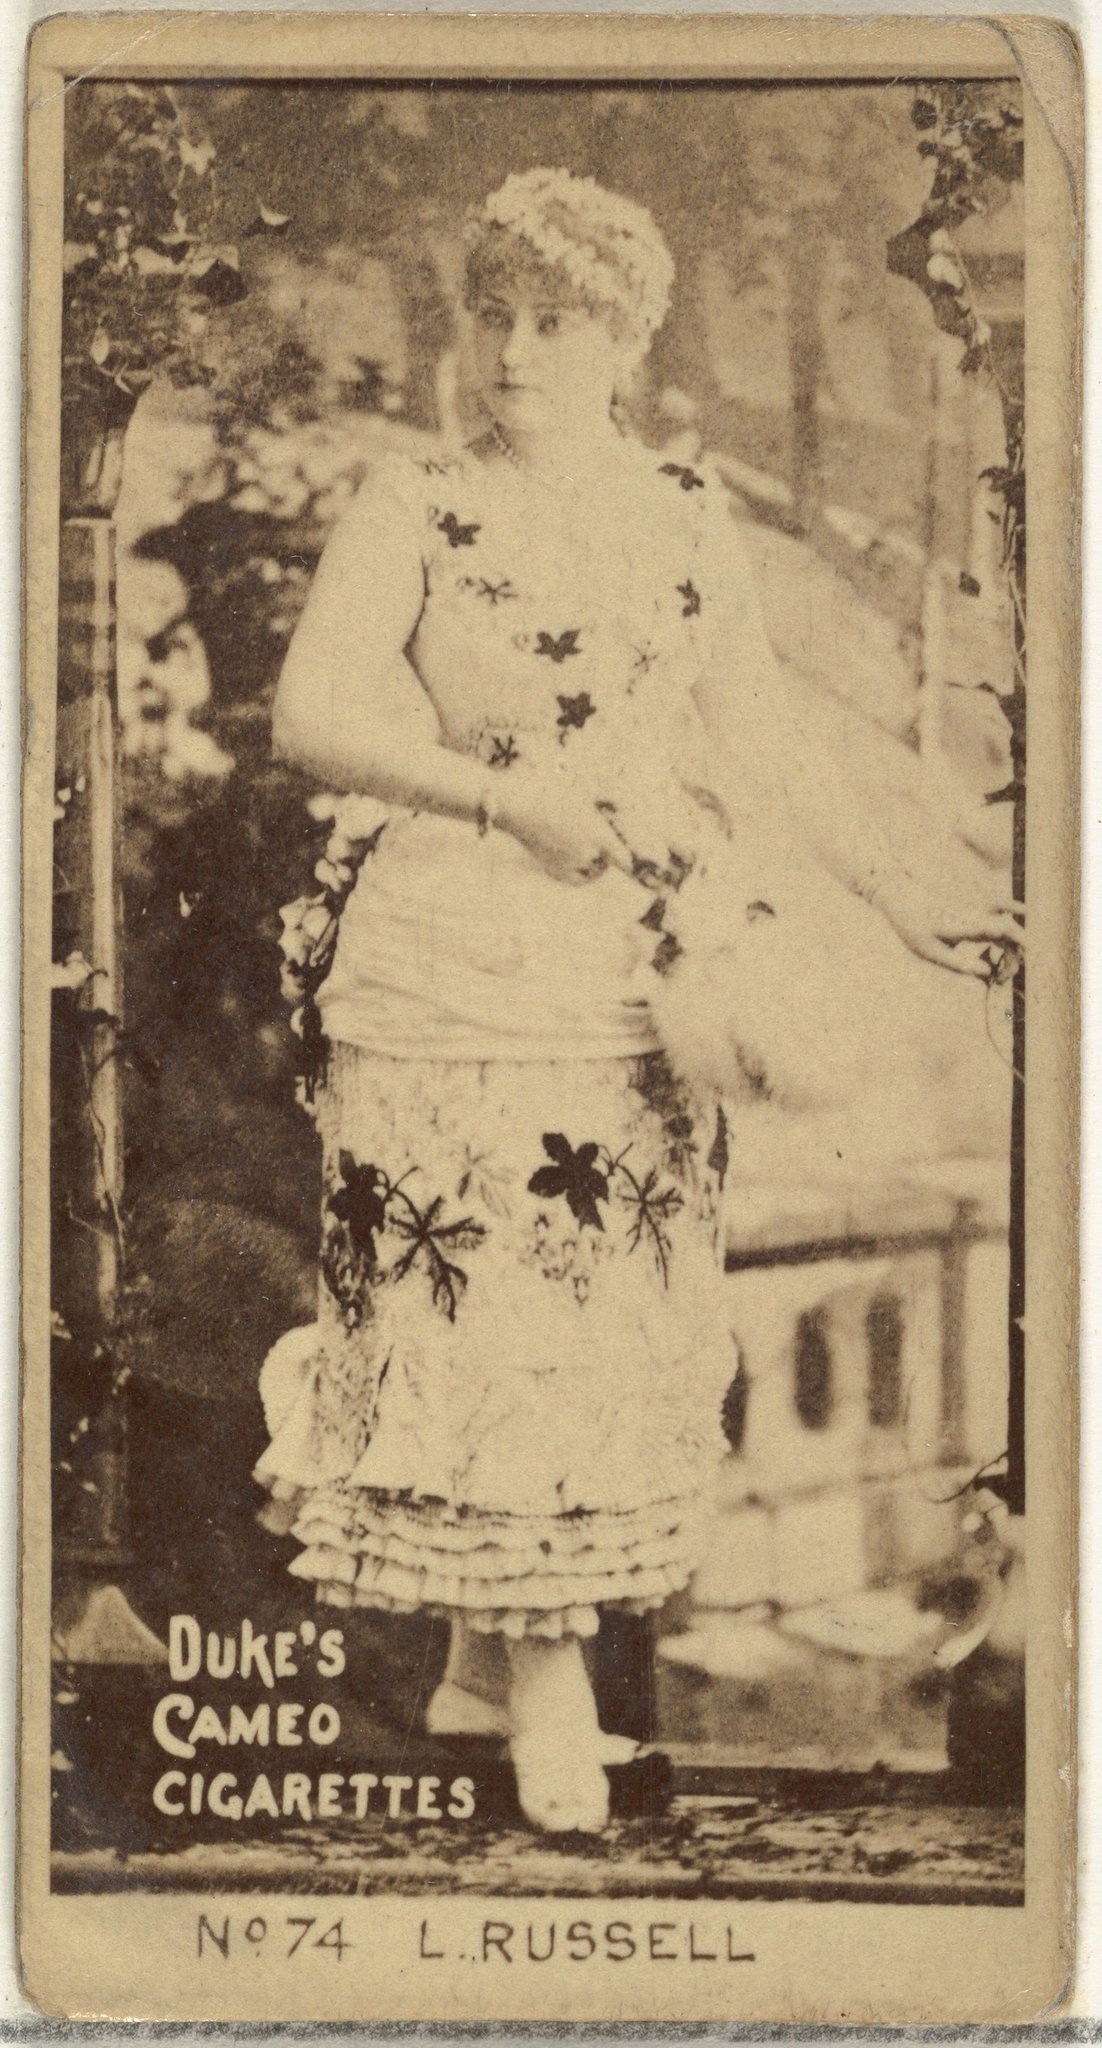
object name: photograph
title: Card Number 74, Lillian Russell, from the Actors and Actresses series (N145-4) issued by Duke Sons & Co. to promote Cameo Cigarettes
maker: w. duke, sons & co.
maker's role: publisher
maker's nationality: american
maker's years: 1870-1920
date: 1880-1889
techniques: albumen silver print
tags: portraits,women,actresses